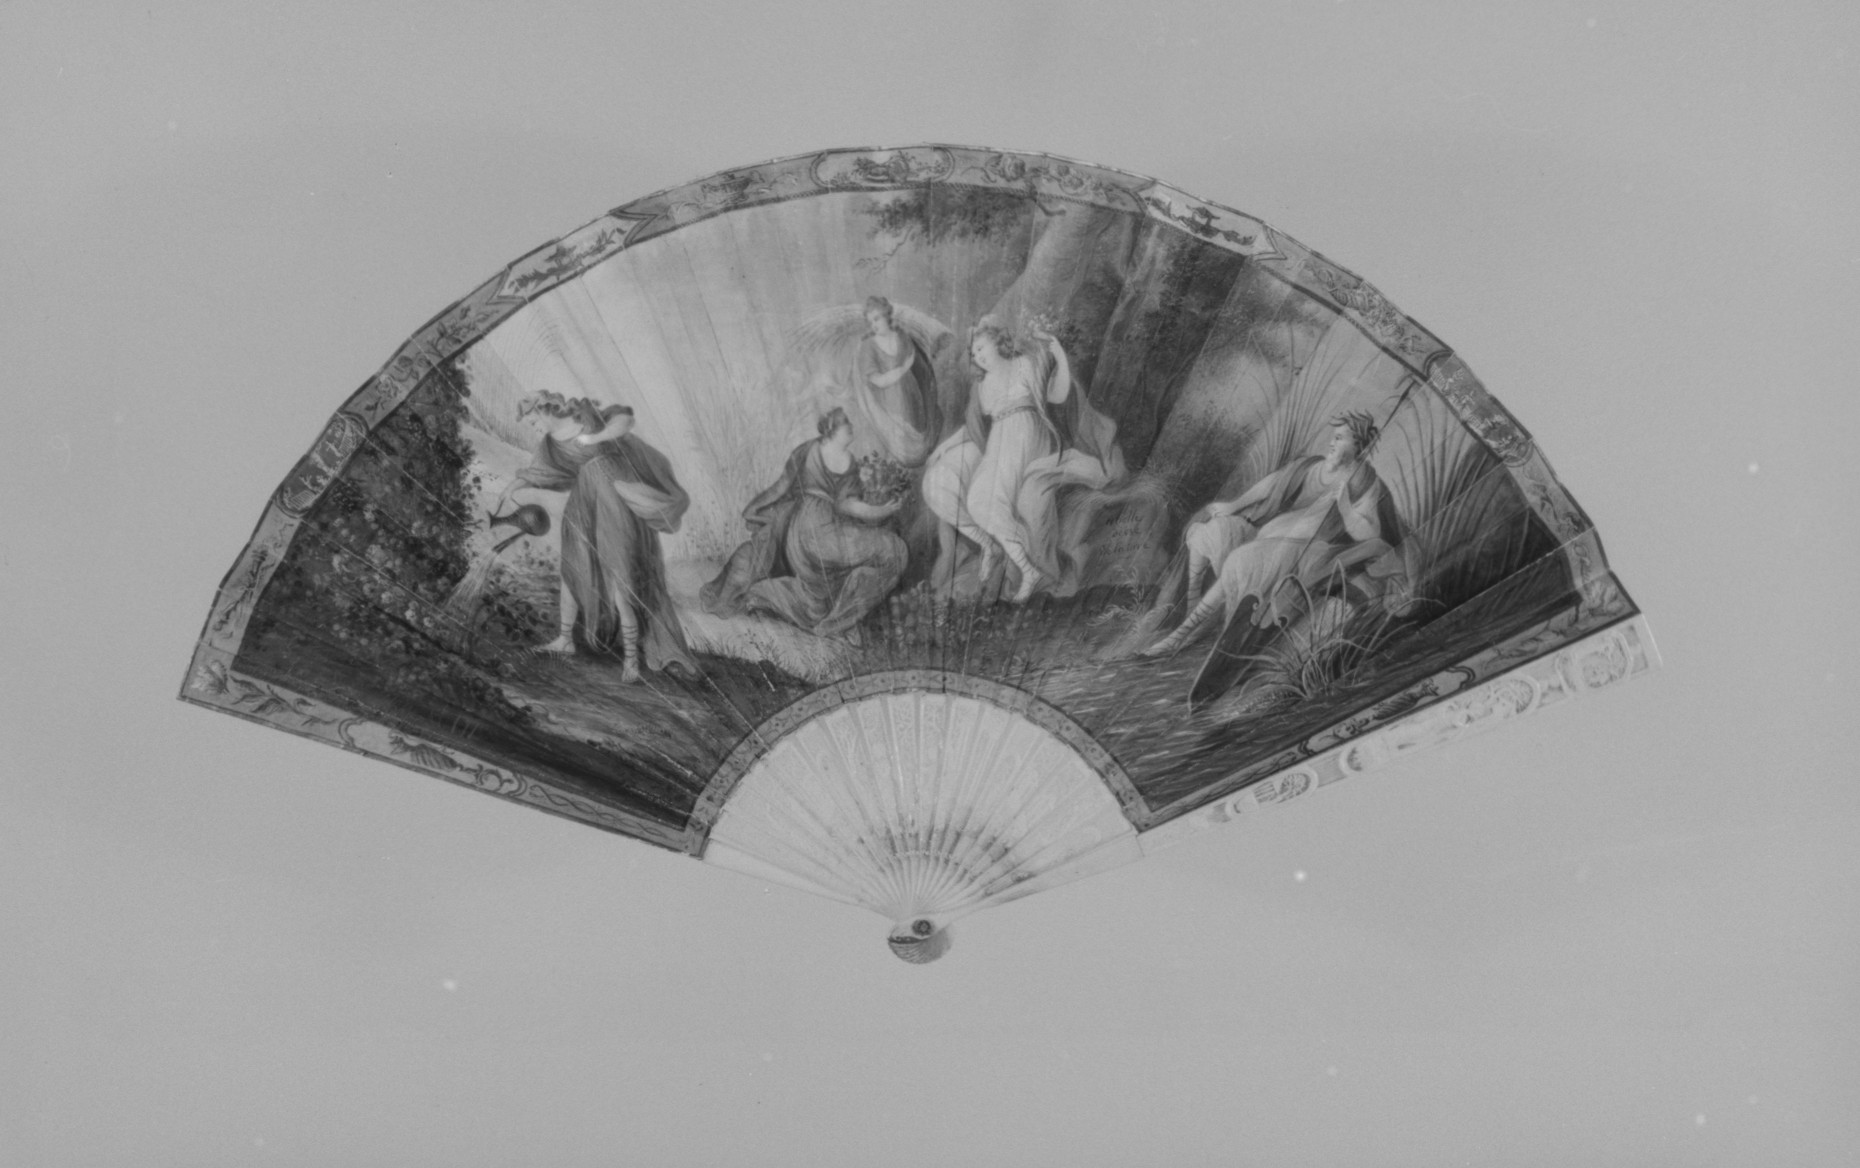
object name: fan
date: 1701-1800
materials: glass, ivory, paper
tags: men,women